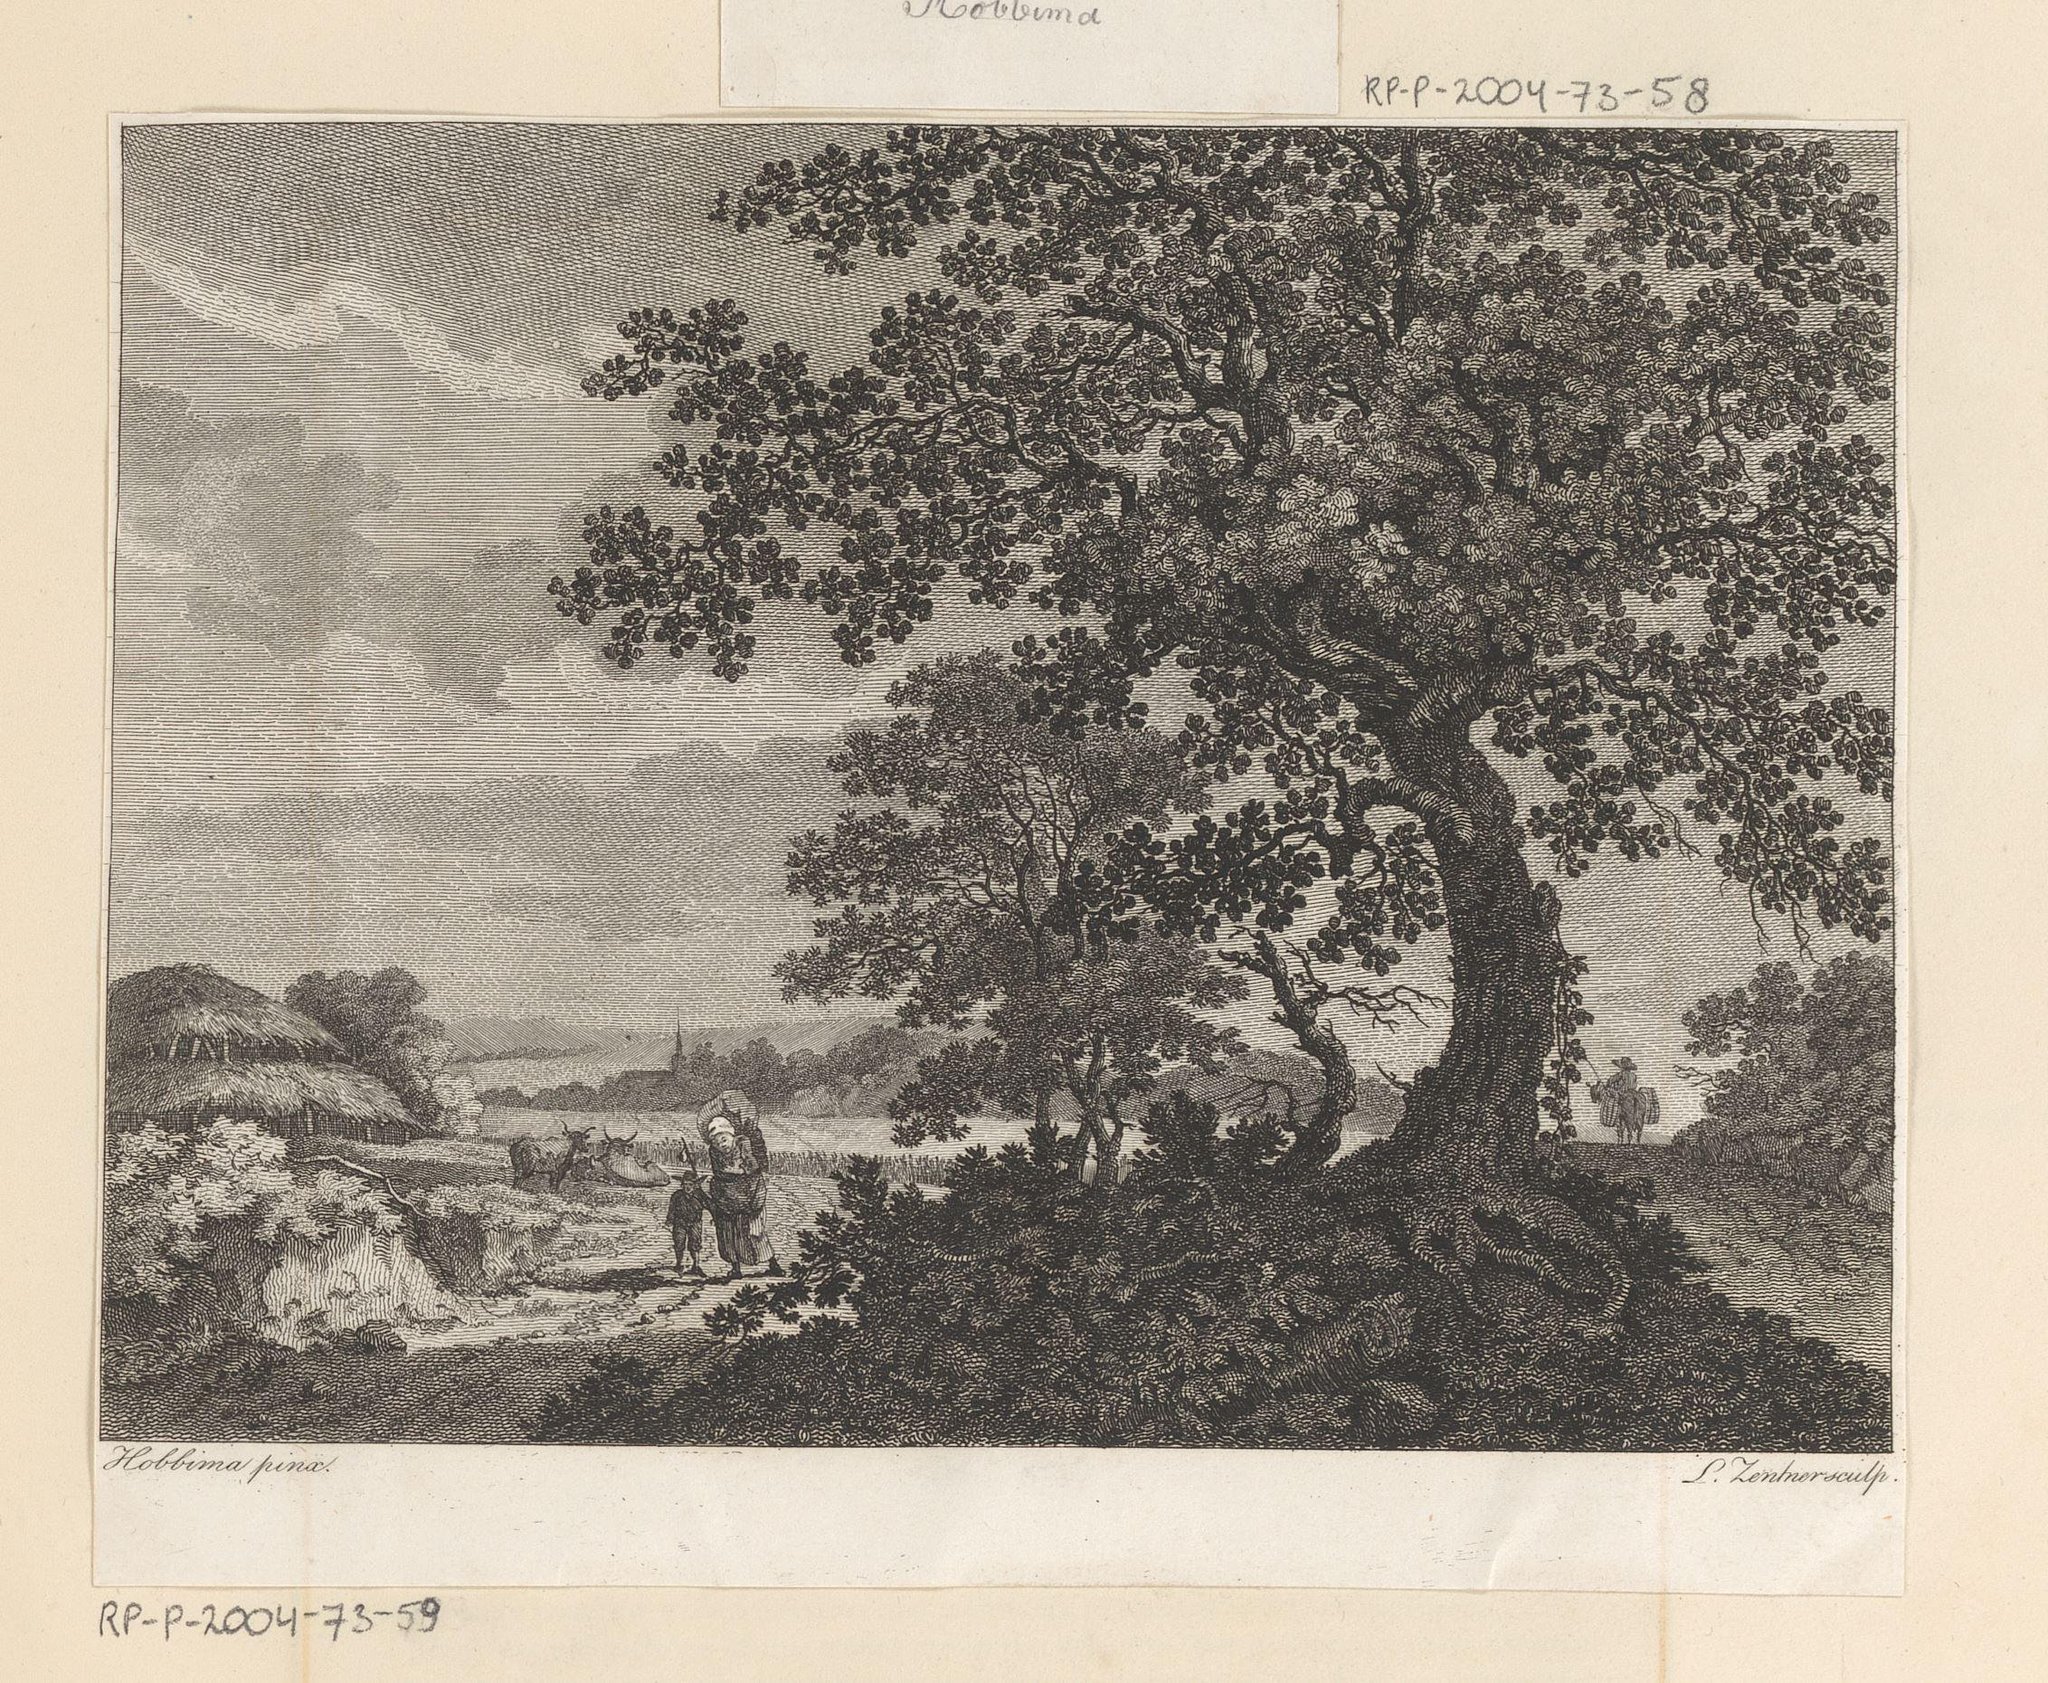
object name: album leaf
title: Landschap met figuren en vee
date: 1791-1798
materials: paper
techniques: engraving, etching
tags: trees, public road (+ city(-scape) with figures, staffage)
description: Prent uit: Zentner, J.L.L.C.. A select Collection of landscapes, from the best old masters, one of each engraved by L. Zentner, after drawings made by him from original pictures (...). Londen: J. Thane, [1791-1798]. De samensteller heeft deze prent in het album geplakt als illustratie bij: Pilkington, Matthew en Johann Heinrich Füssli. A dictionary of painters, from the revival of the art to the present period. 4 dln. Londen: John Crowder, 1805, dl. 2, p. 246.